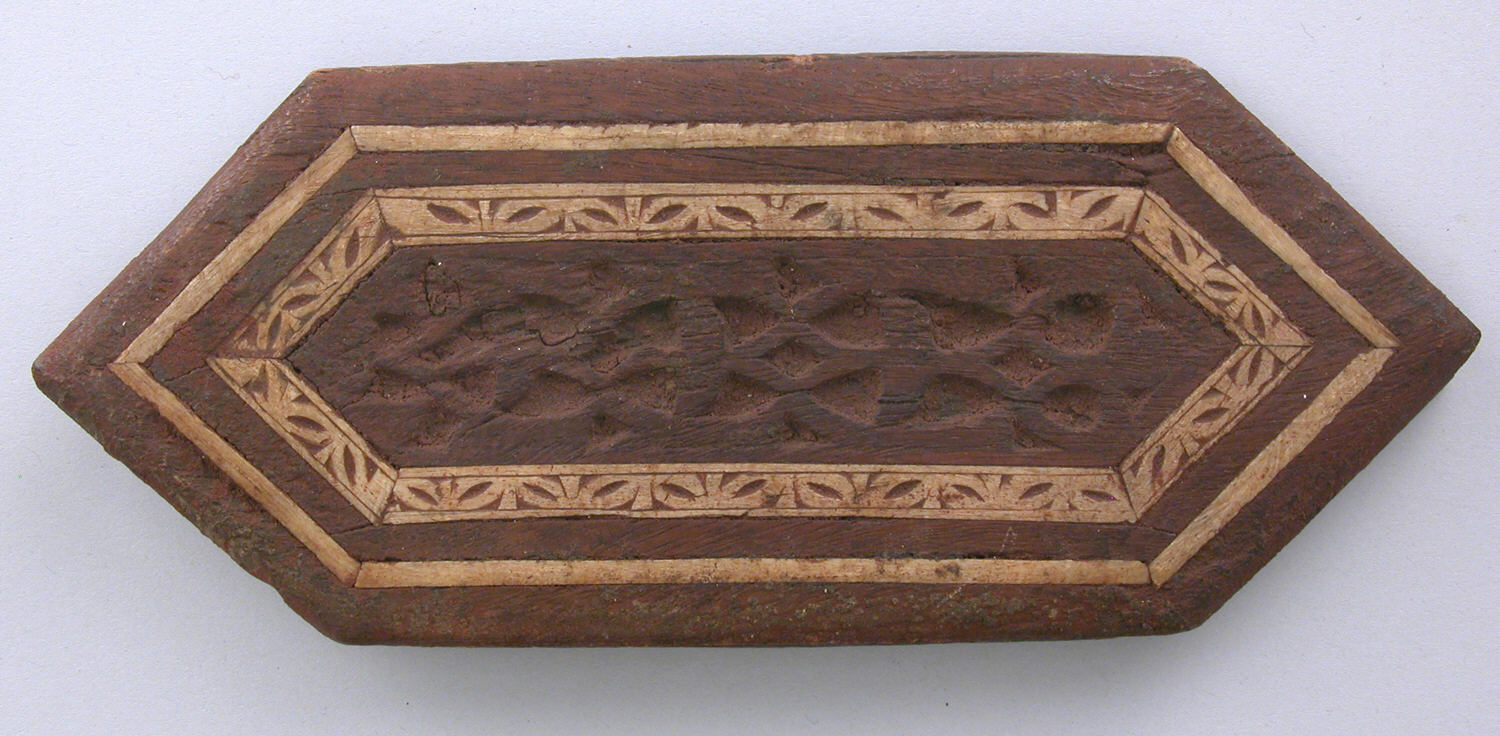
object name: panel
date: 1301-1500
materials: ivory, wood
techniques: carving, inlay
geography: egypt